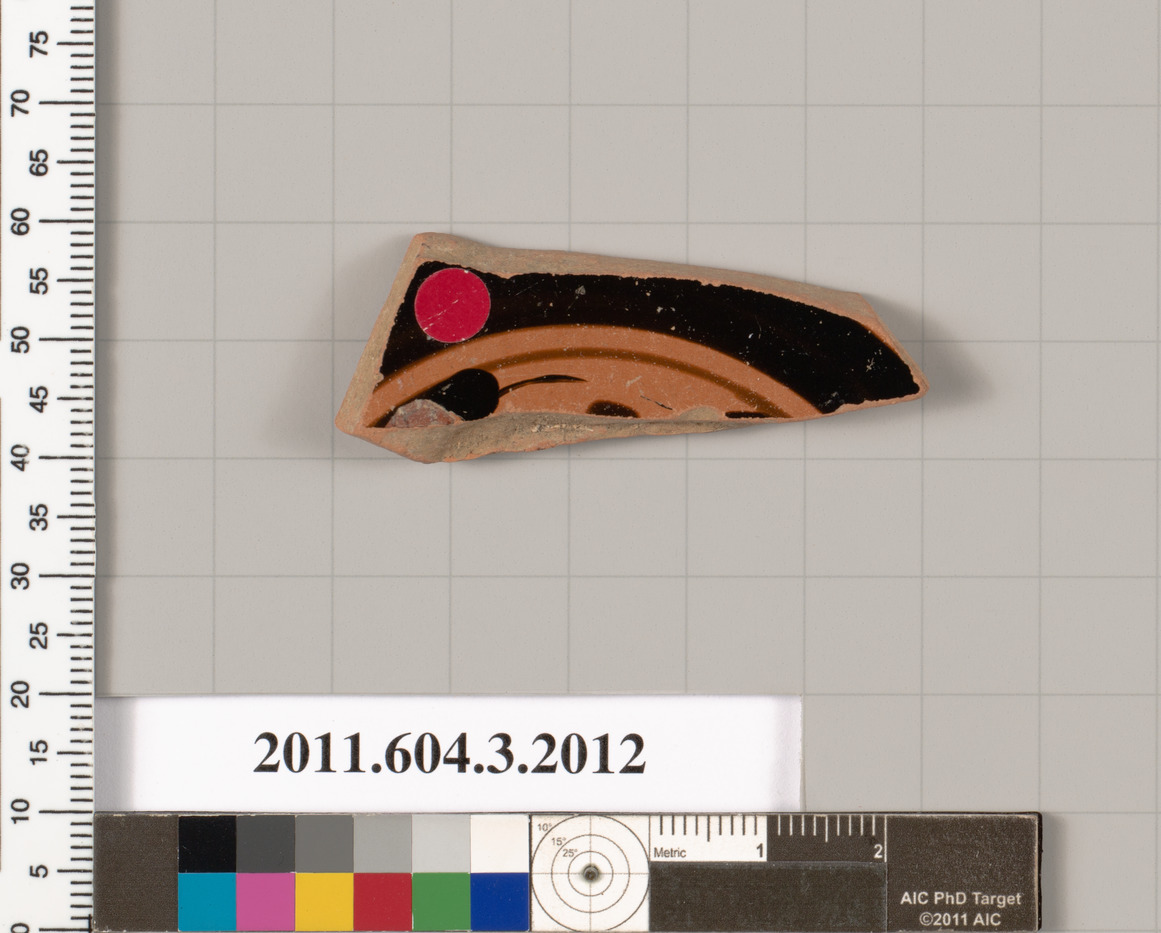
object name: kylix fragment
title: Terracotta fragment of a kylix (drinking cup)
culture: greek, attic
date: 550-526 BCE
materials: terracotta